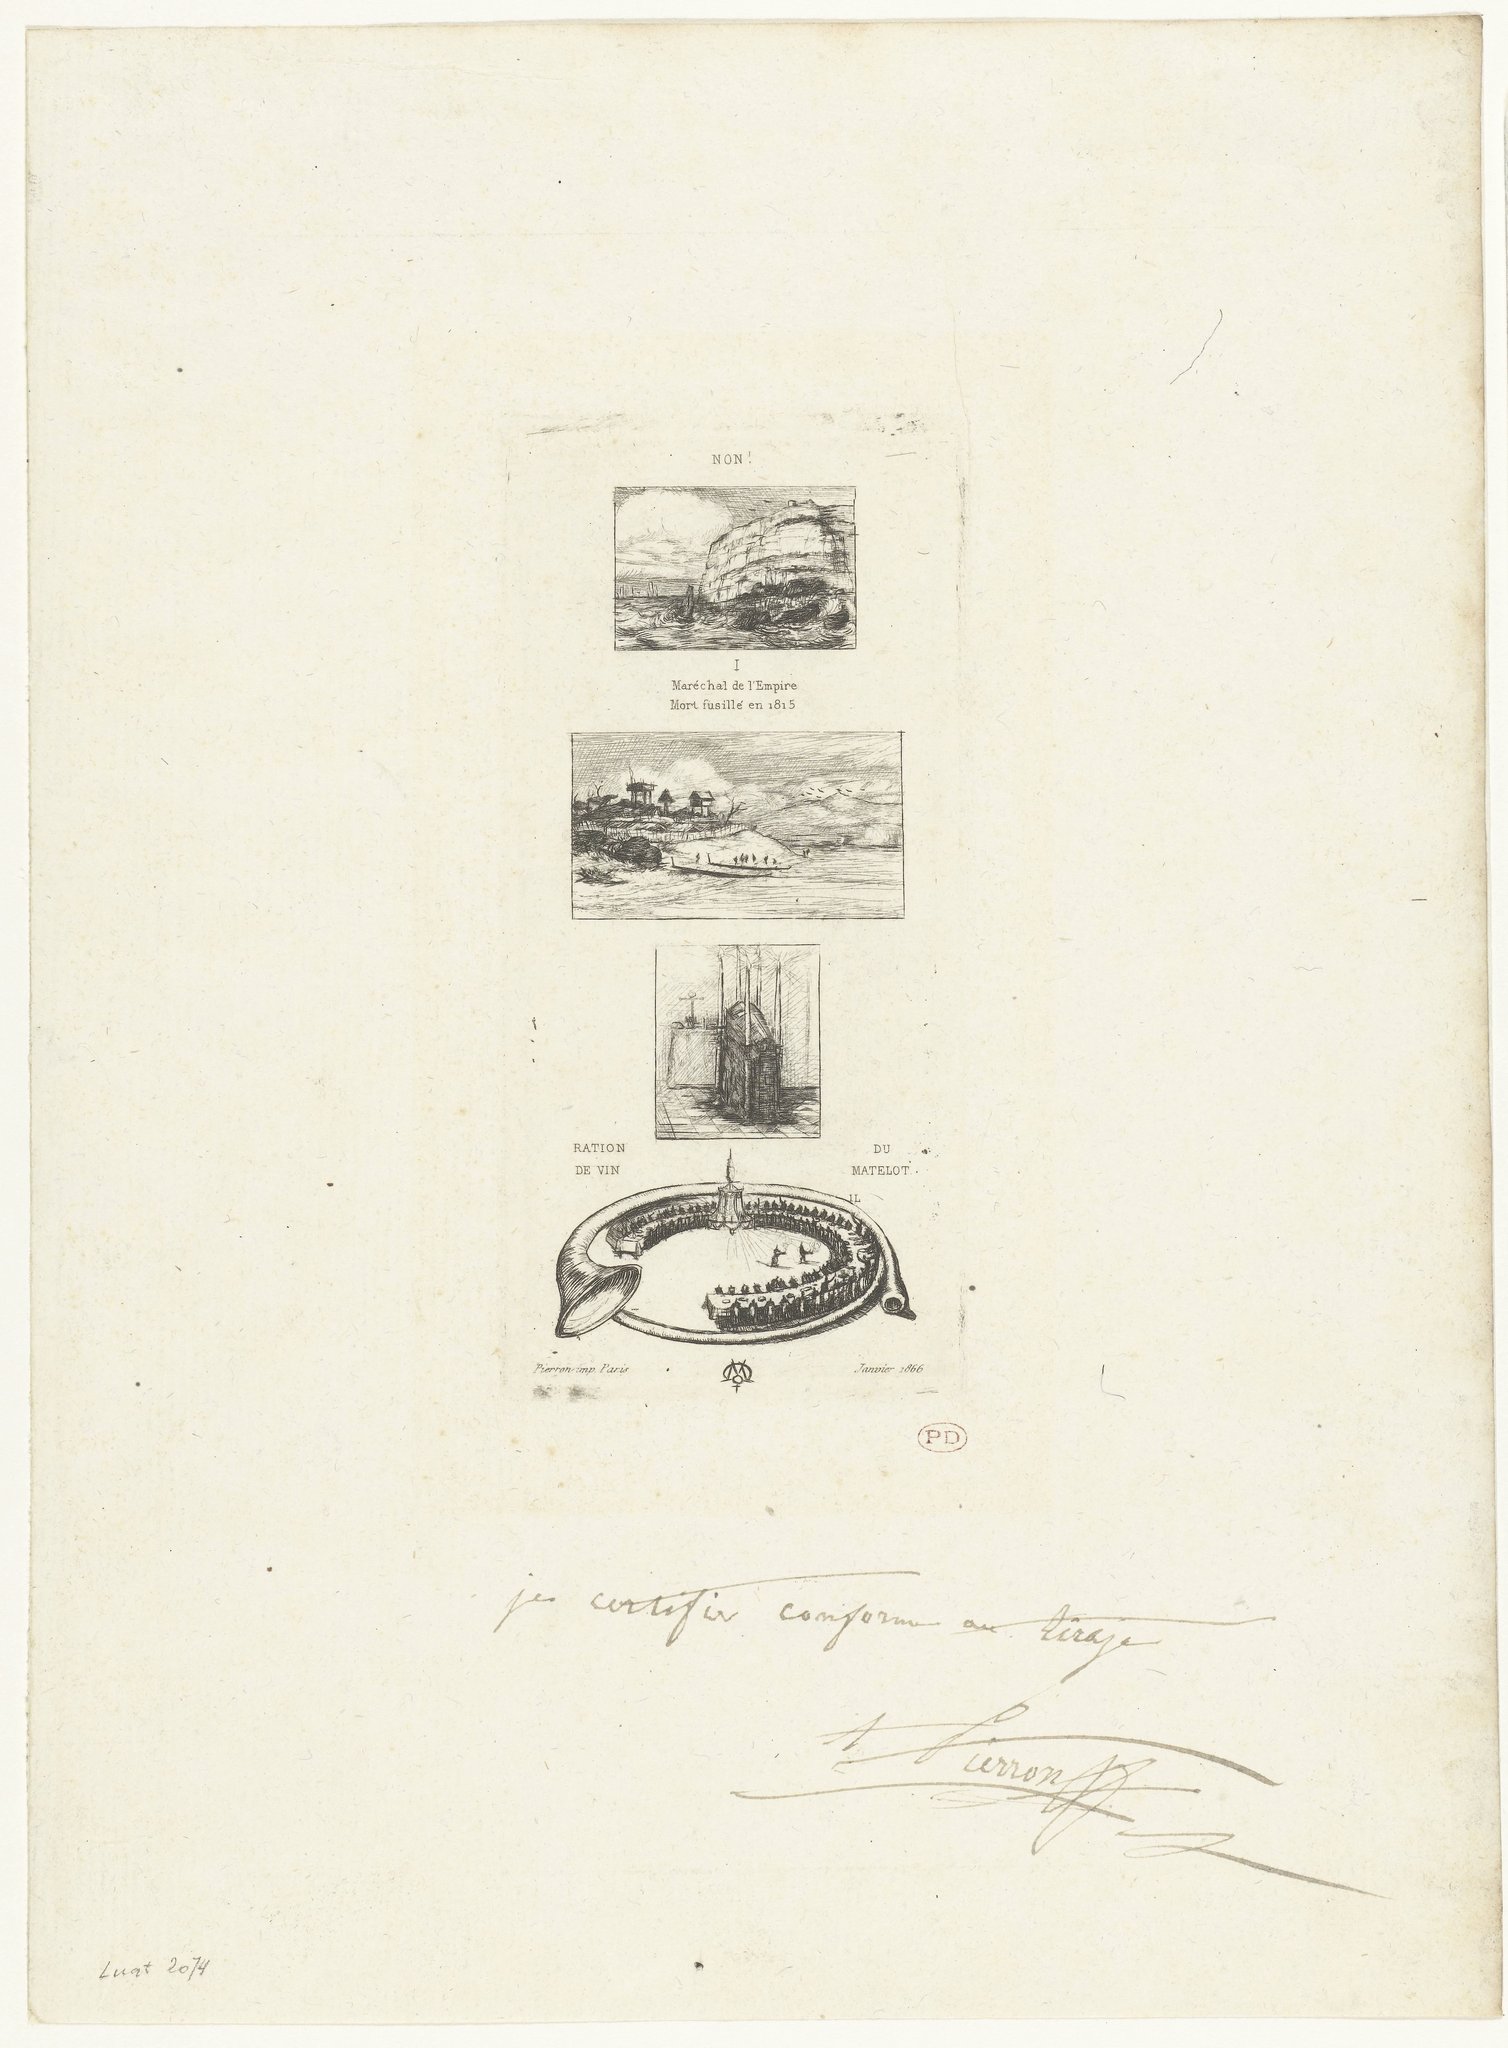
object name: print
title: Rébus: Non! Morny n'est pas mort car il noce encore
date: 1801-1866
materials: paper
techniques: etching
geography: france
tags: horn, trumpet, cornet, trombone, tuba, rocky coast, coffin, rebus, celebration meal, feast, banquet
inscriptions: collector's mark: Lugt 2074, collector's mark: verzamelaarsmerk R. Vroom, inscription: ‘je certifie conforme au tirage/ A Pierron’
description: Vier voorstellingen maken deel uit van een rebus en vormen samen de tekst Non! Morny n'est pas mort car il noce encore. Eerste afbeelding: rots aan zee met bootjes, tweede afbeelding: huisjes op palen aan strand, derde afbeelding: doodskist bij altaar, vierde afbeelding: banket aan ronde tafel in cirkel, die de vorm van een trompet heeft.